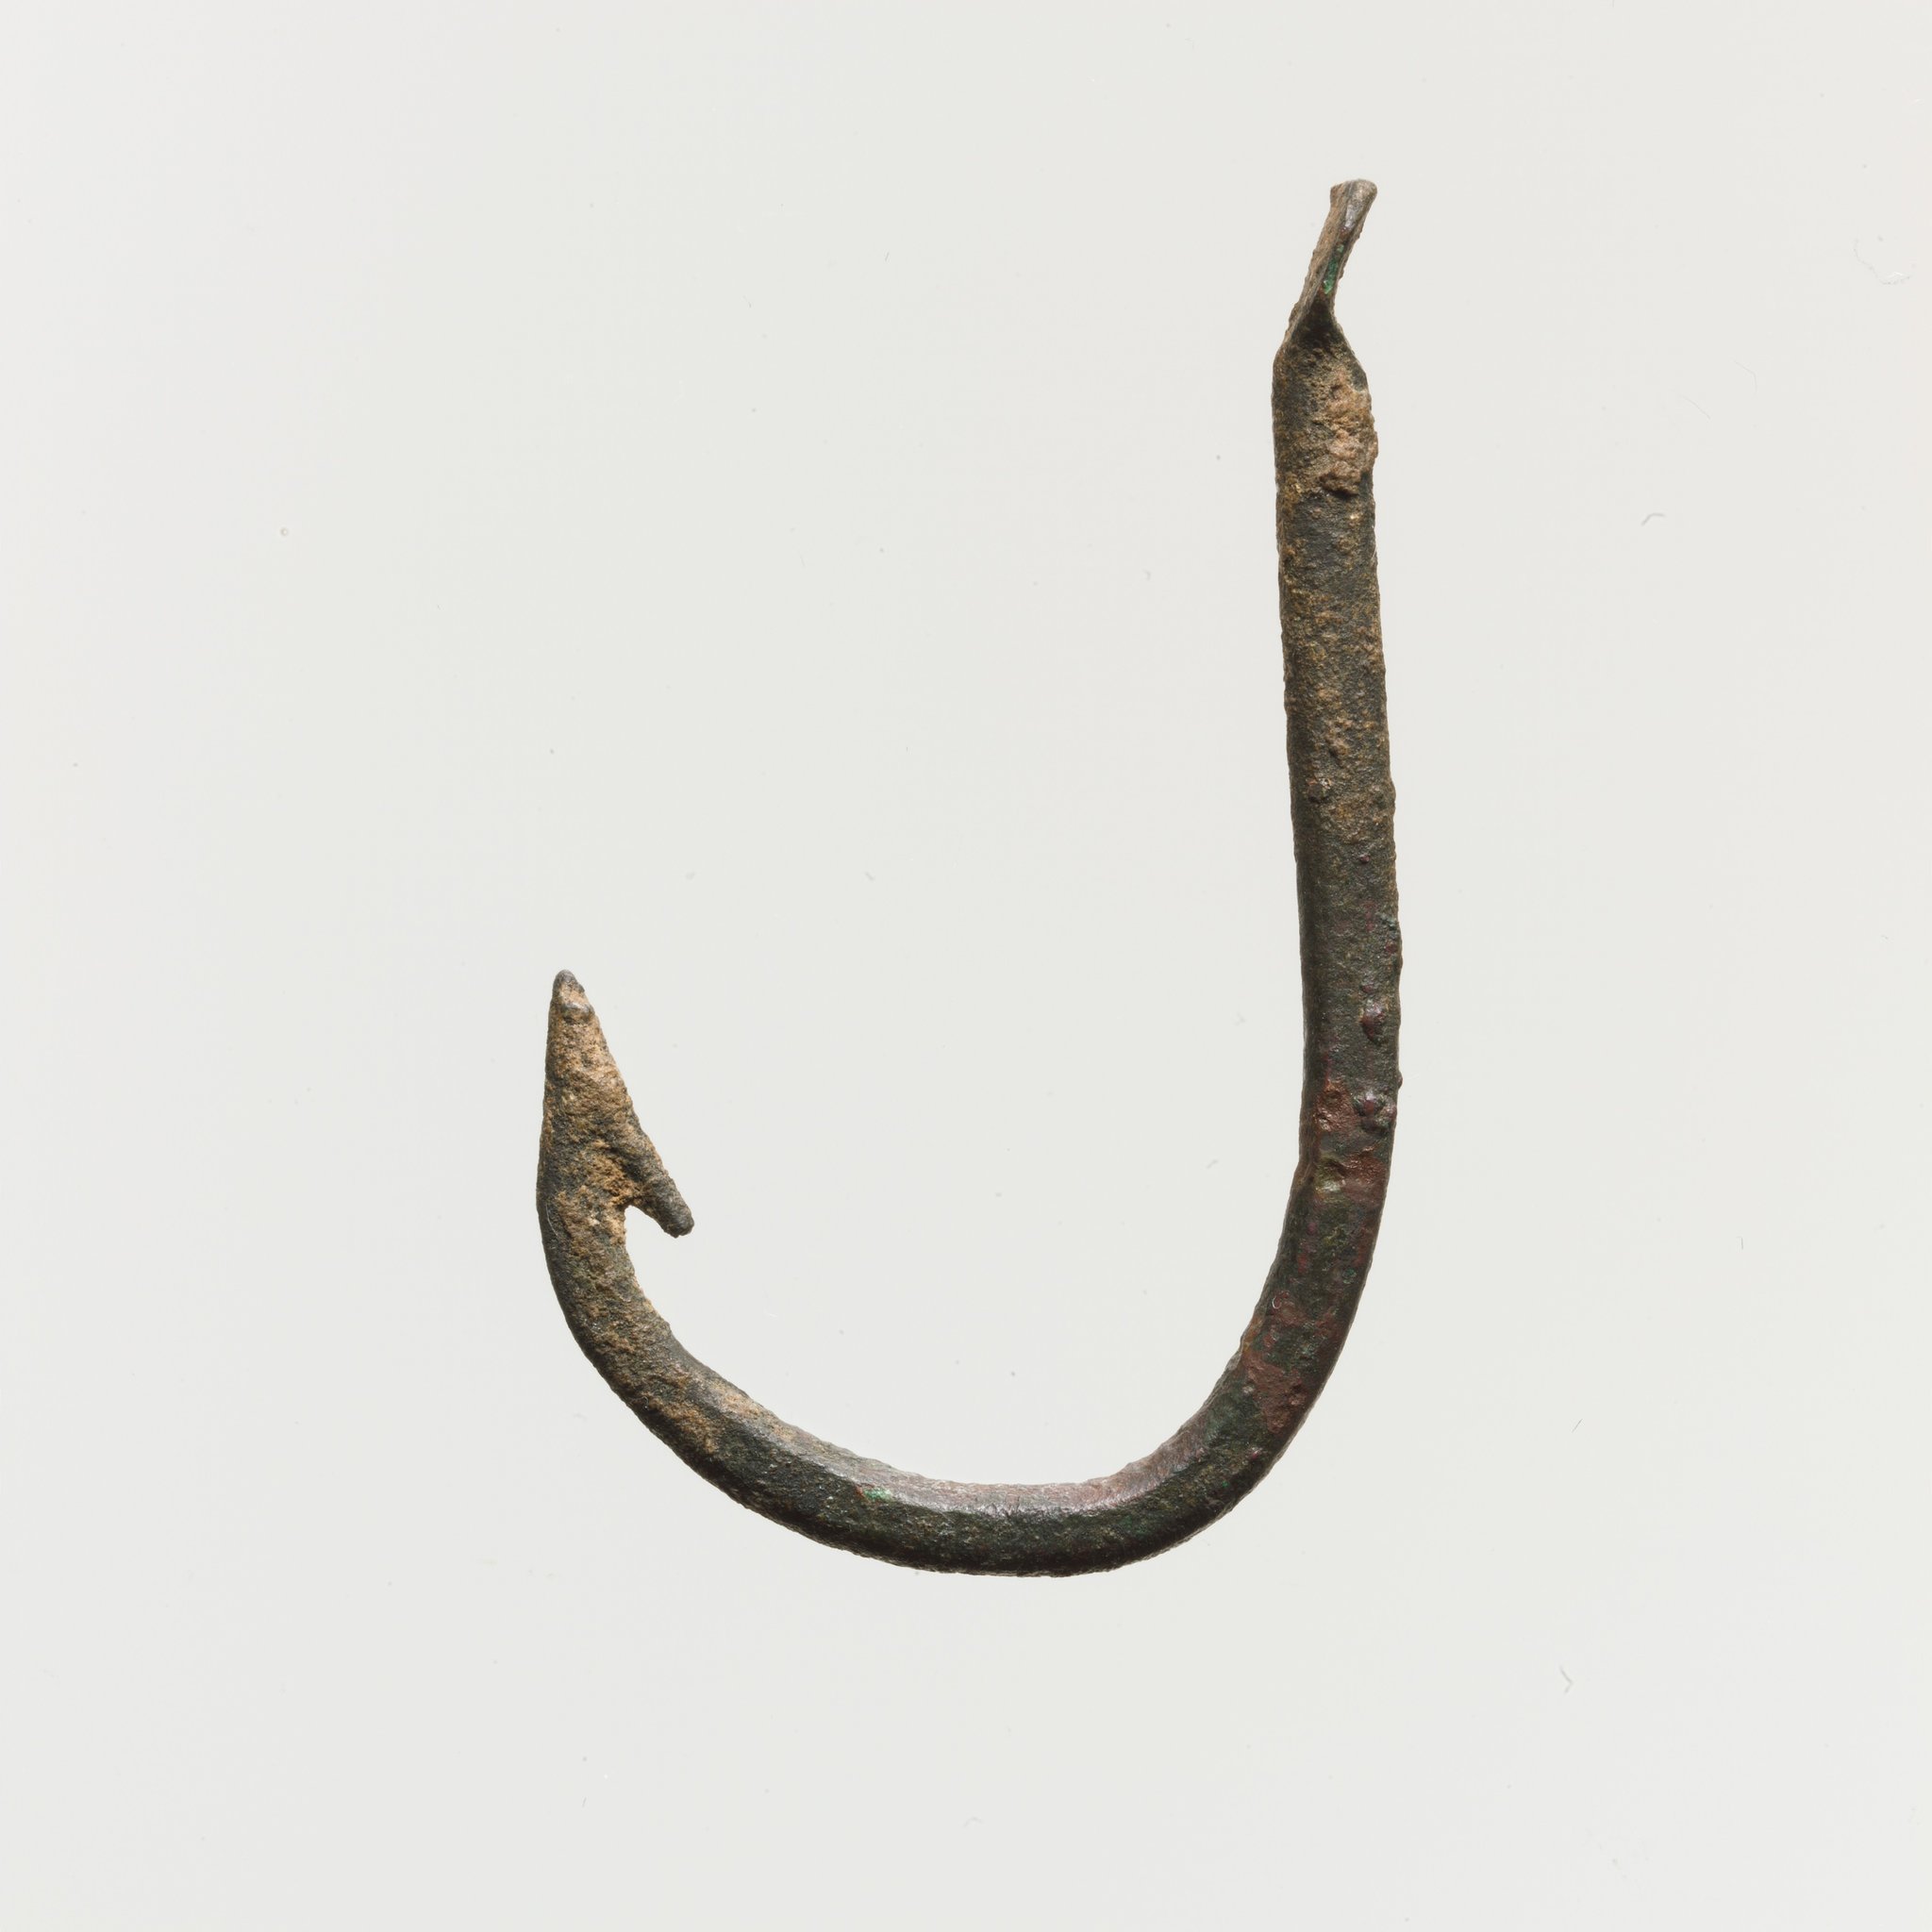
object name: fish hook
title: Bronze fish hook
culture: minoan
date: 2400-1450 BCE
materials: bronze